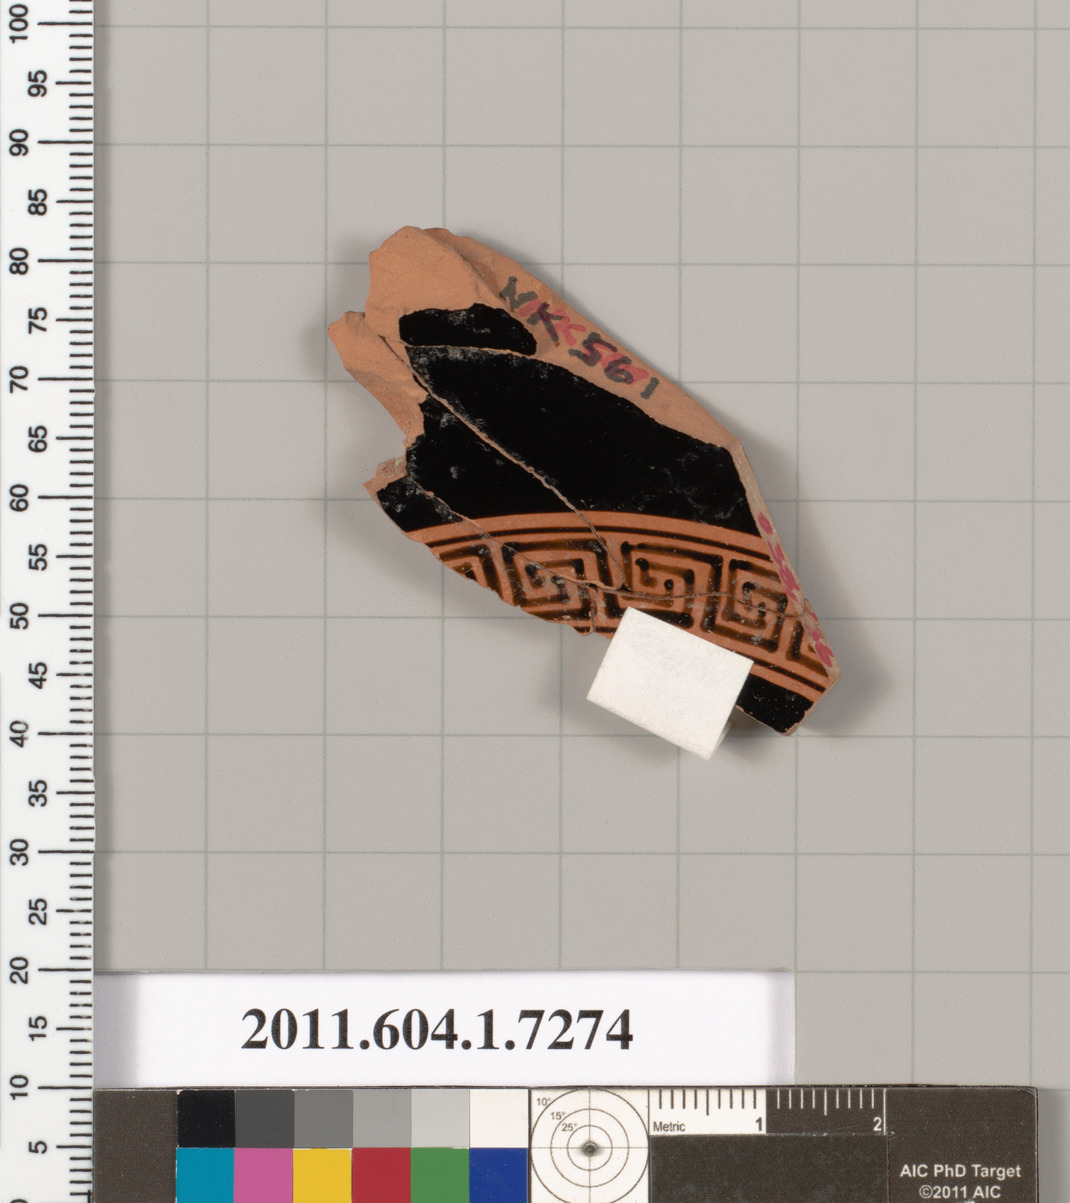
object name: kylix fragment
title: Terracotta fragment of a kylix (drinking cup)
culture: greek, attic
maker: makron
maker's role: artist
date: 500-480 BCE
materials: terracotta